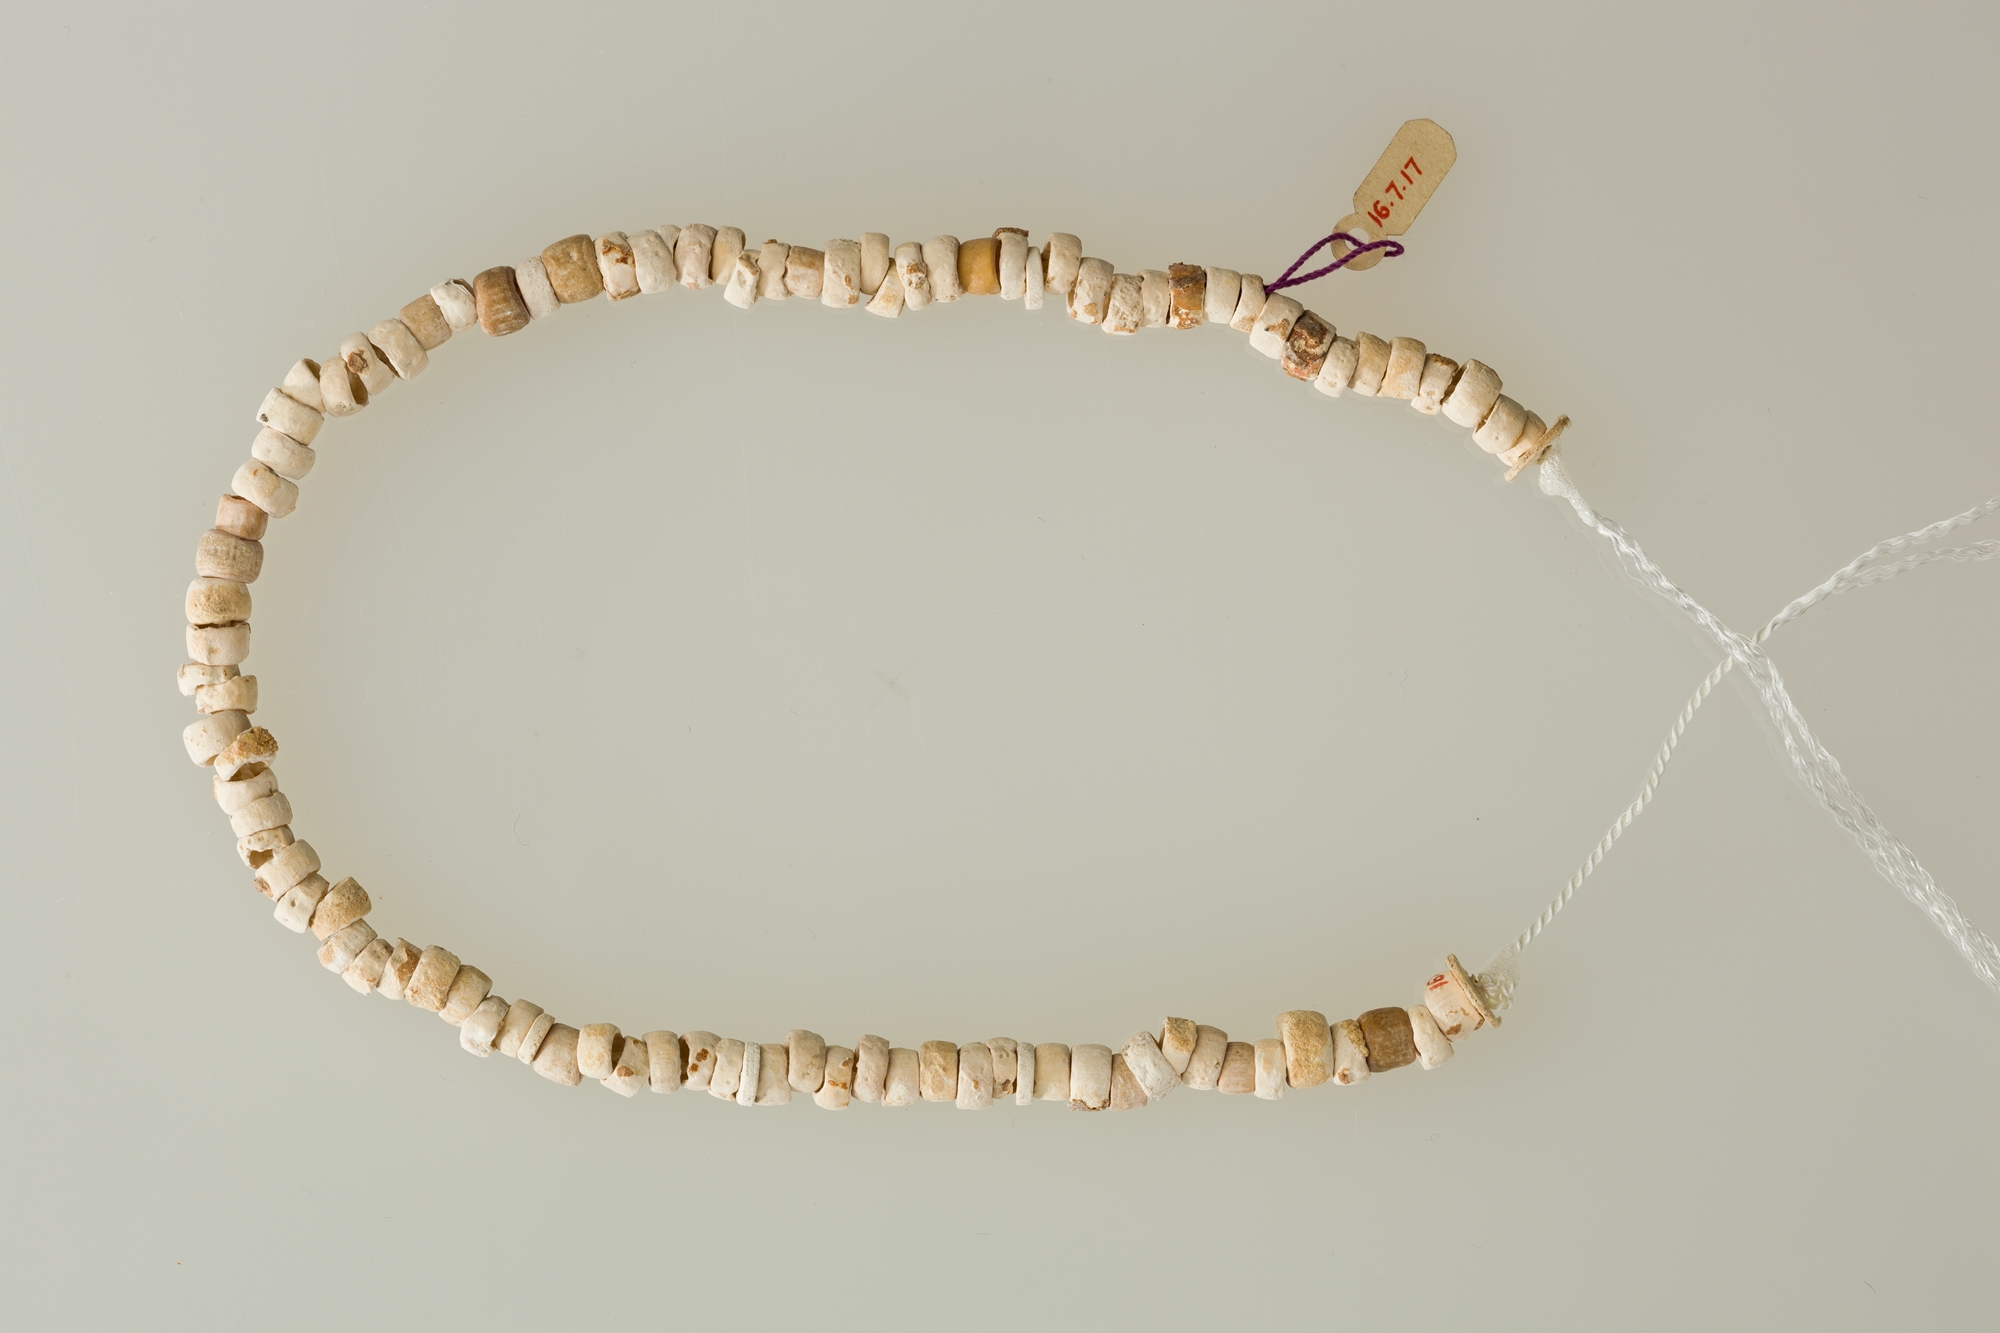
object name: bead, string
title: Beads, string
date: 3850-2960 BCE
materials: bone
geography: egypt